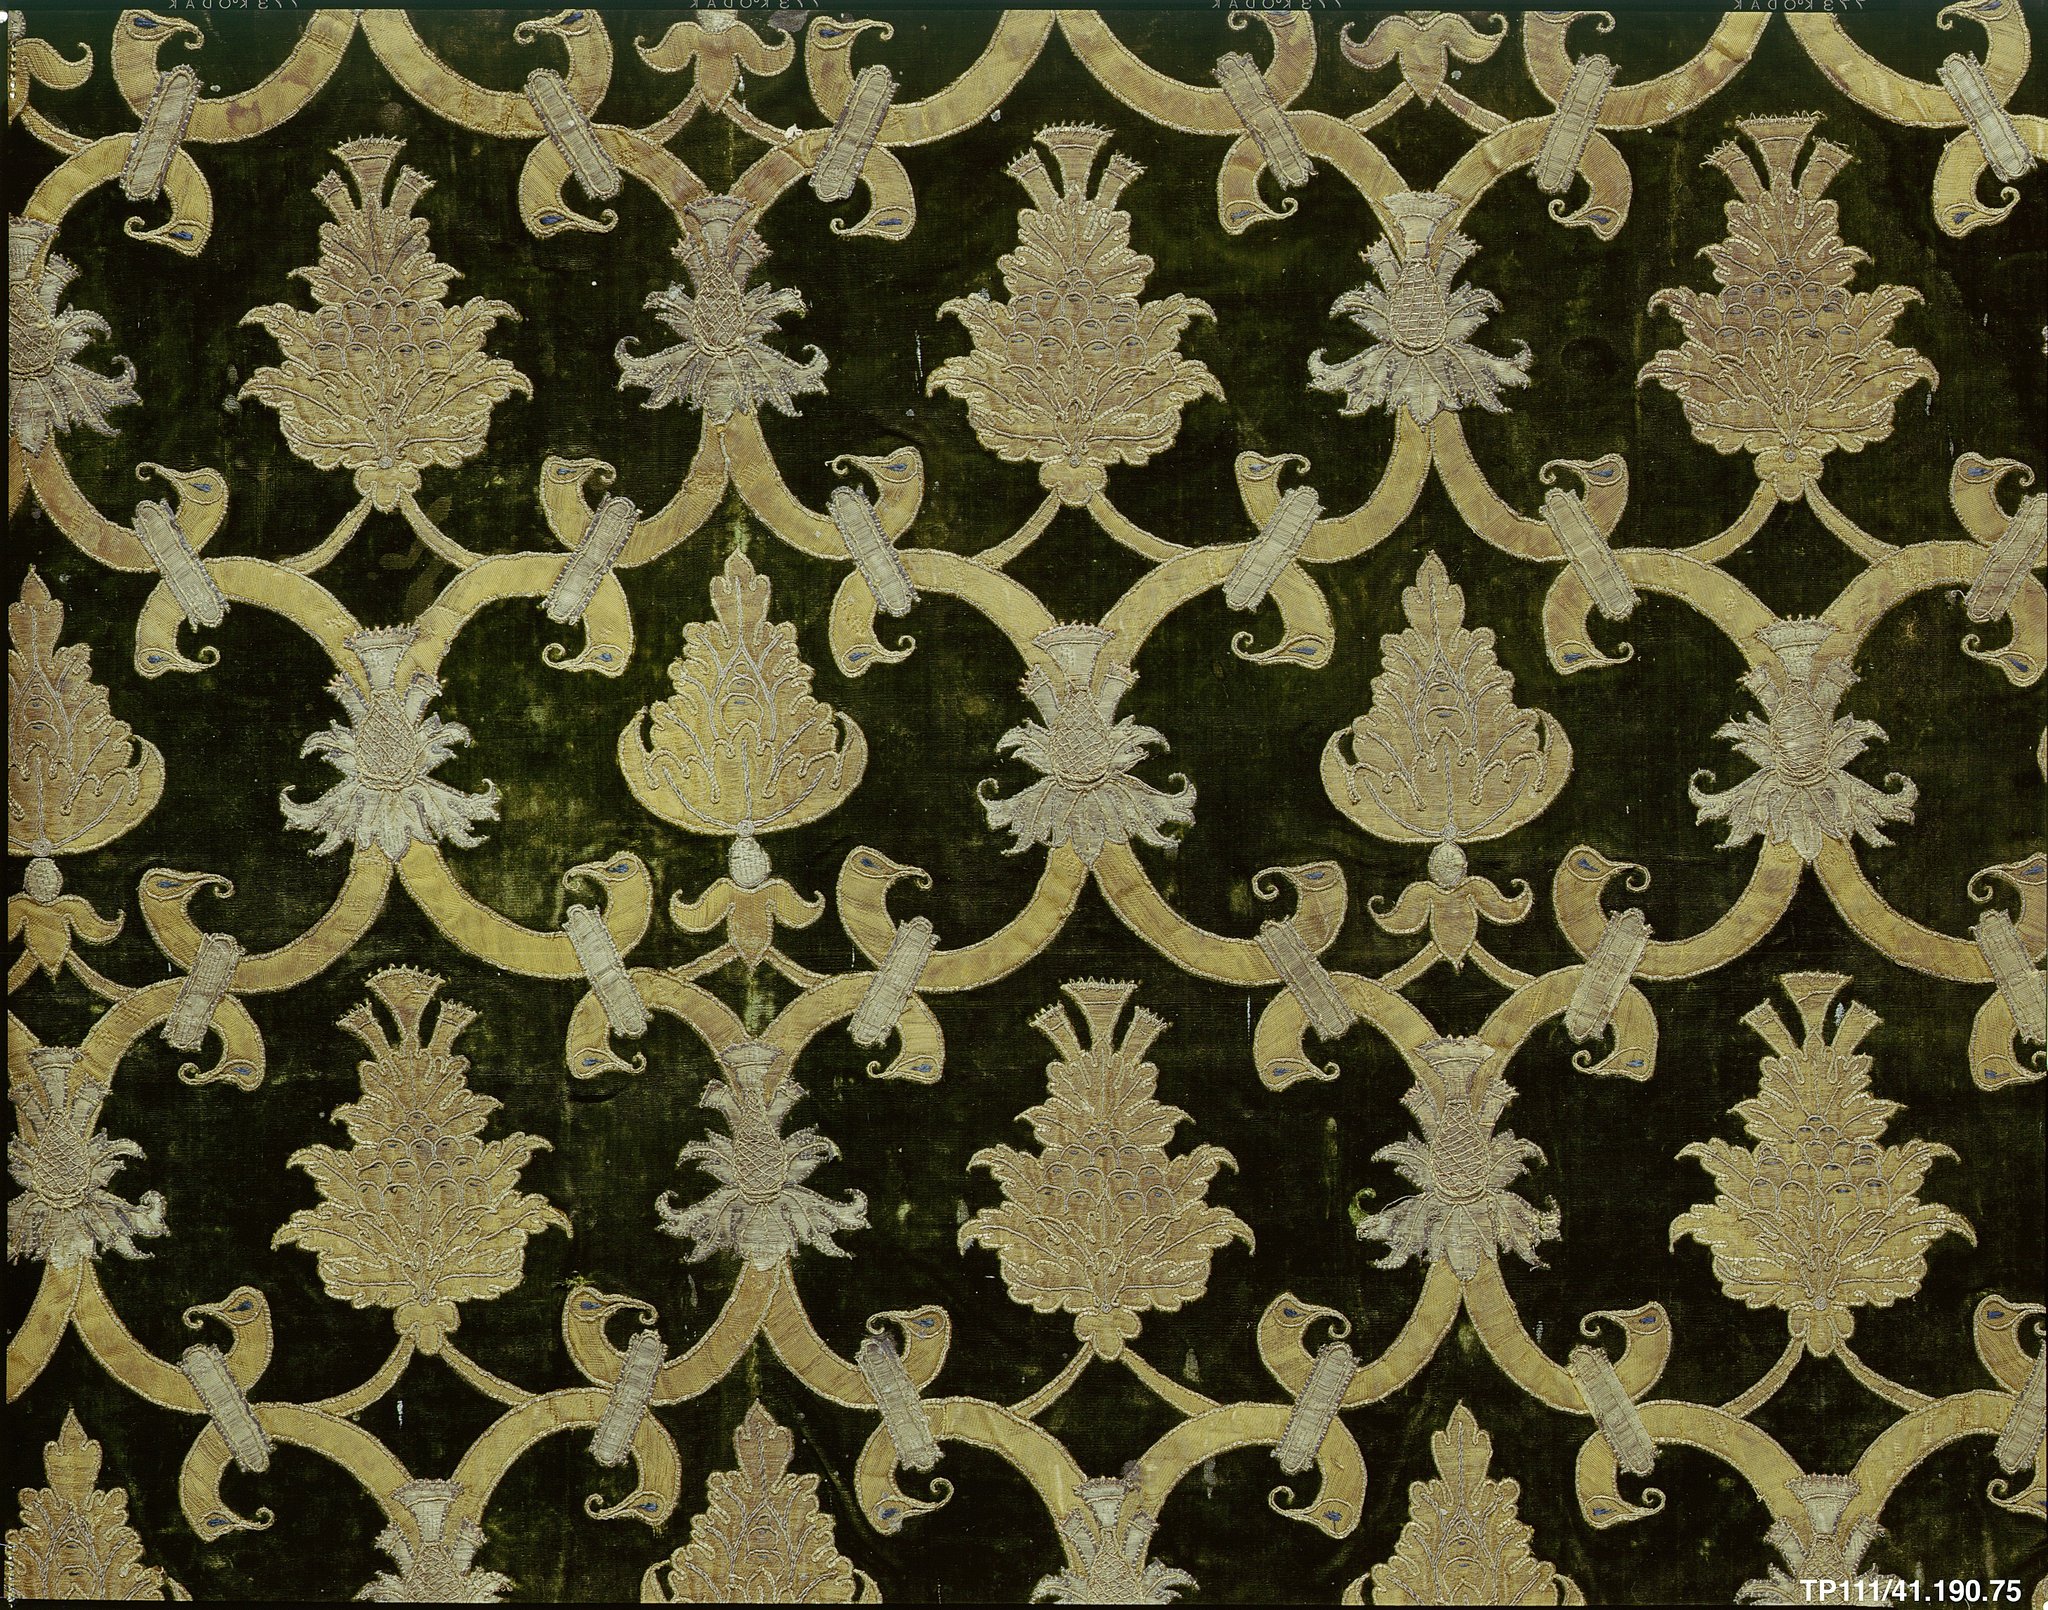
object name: runner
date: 1501-1700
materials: metal thread, silk